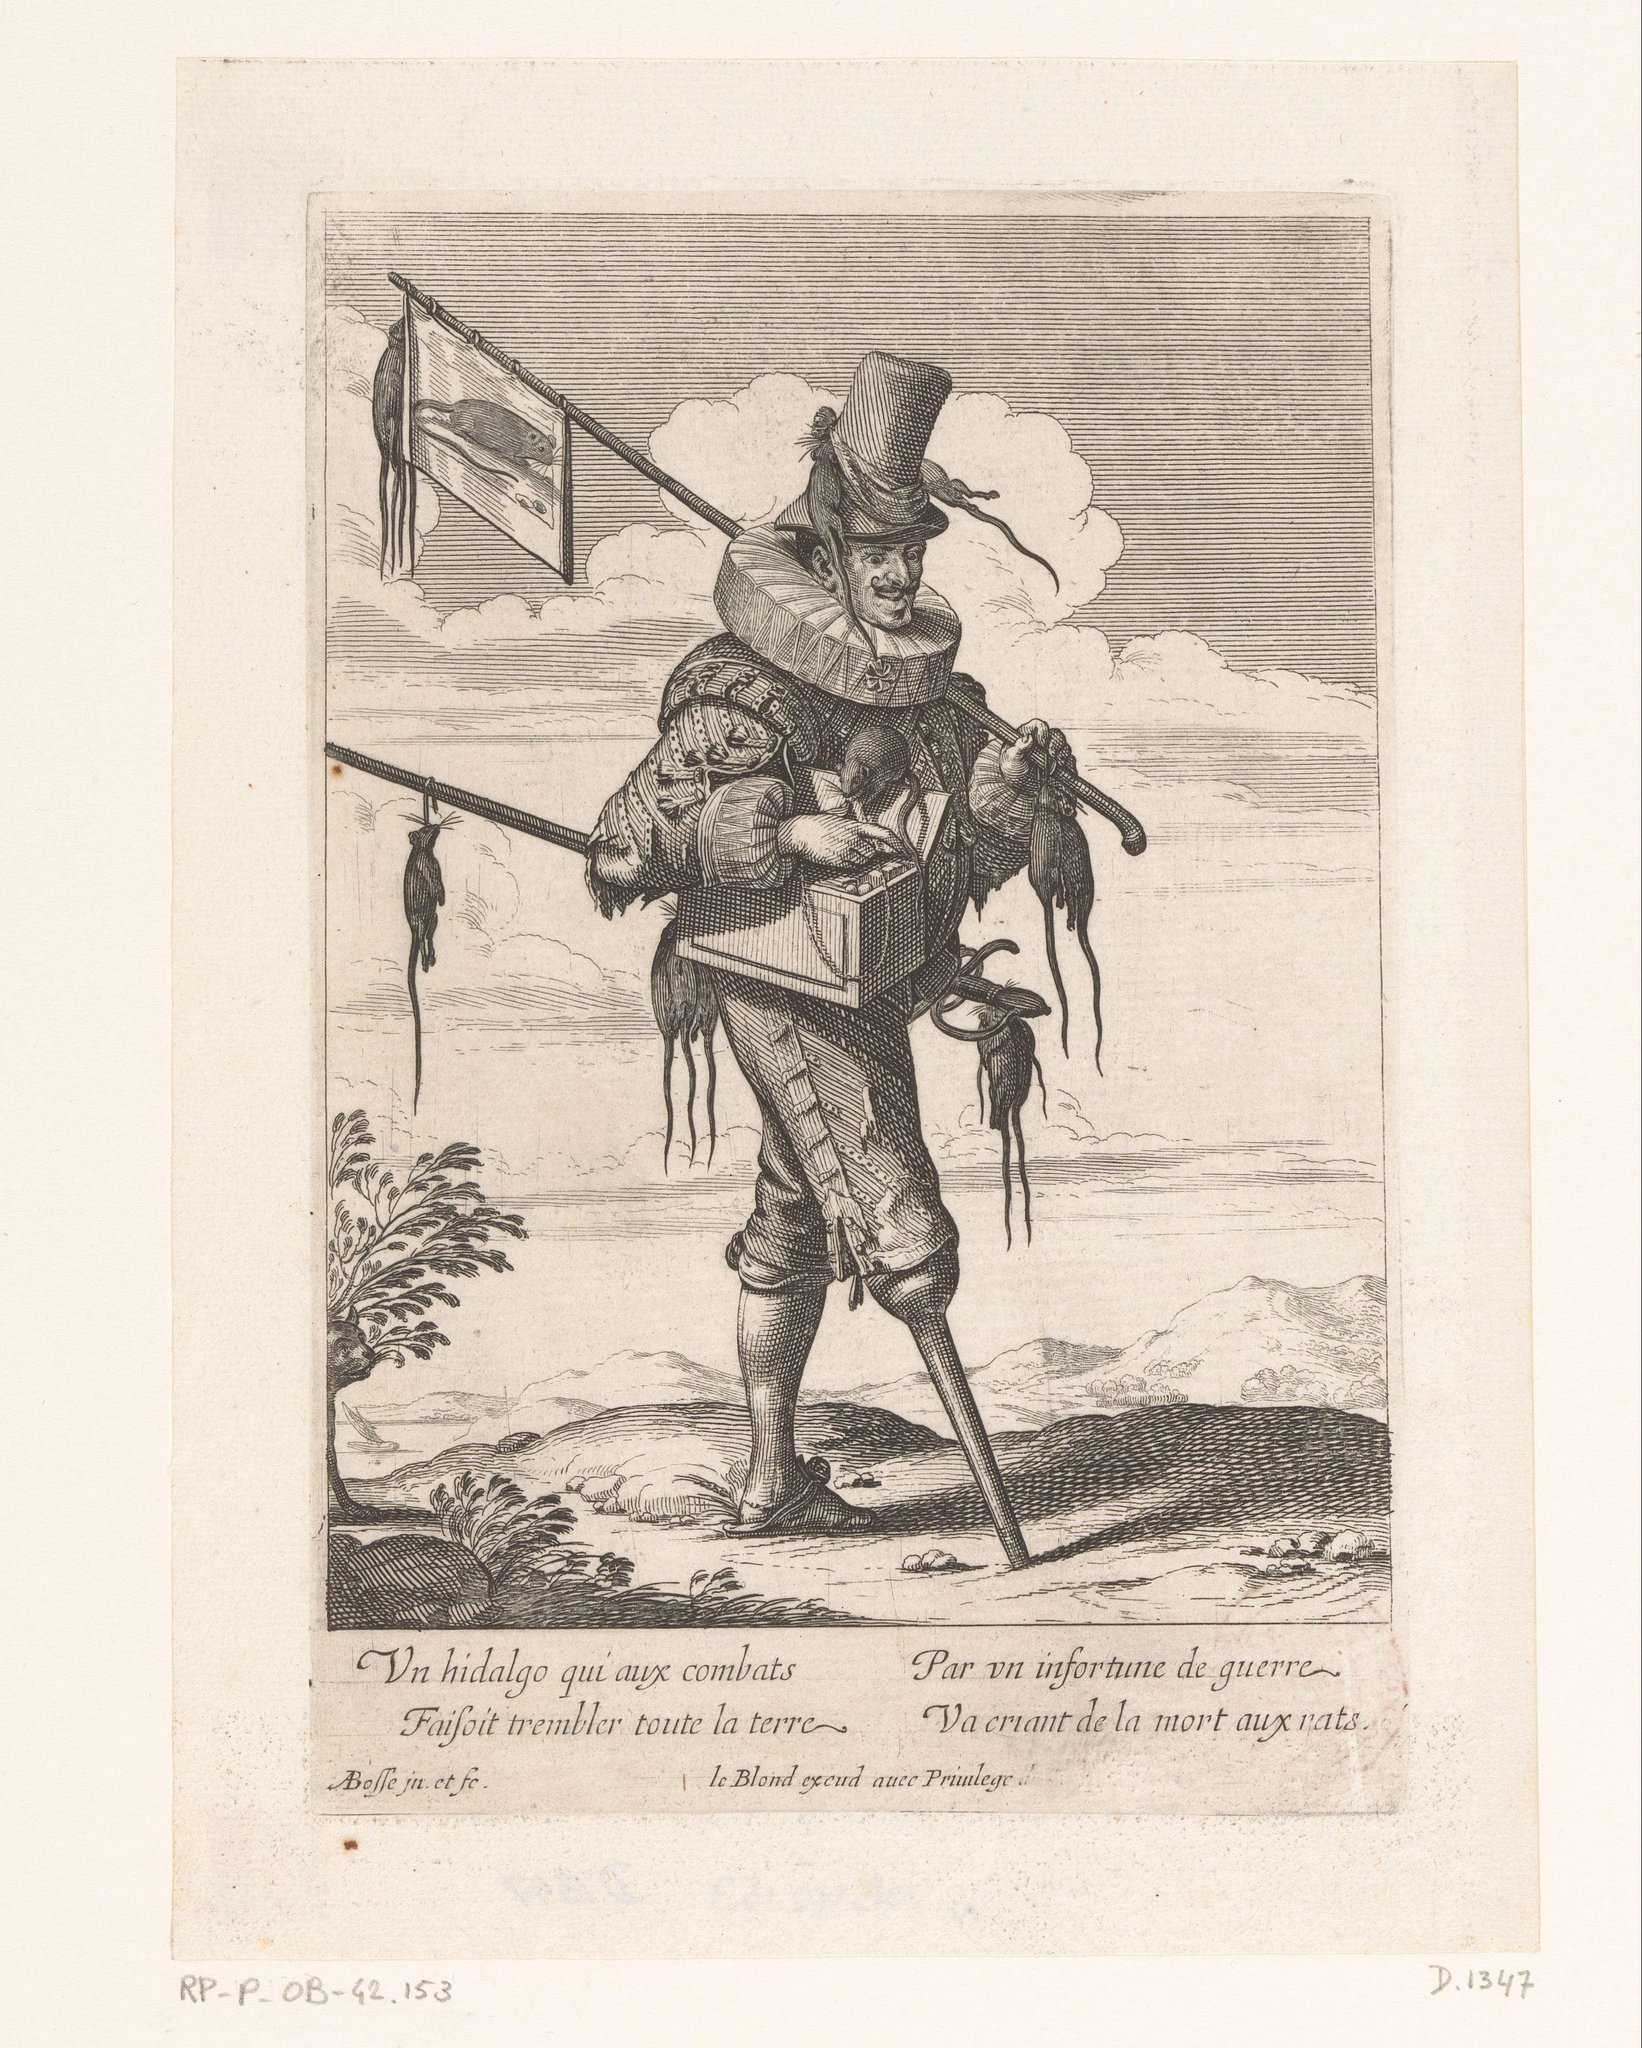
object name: print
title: Spaanse rattenvanger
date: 1629-1630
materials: paper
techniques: engraving, etching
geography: paris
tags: europeans: spaniards, rodents: rat, rat exterminator, wandering or travelling merchant, merchant, salesman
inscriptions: collector's mark: Lugt 240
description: Maakt deel uit van een serie van twaalf prenten met straatverkopers en dienstverleners, uitgegeven door Jean Leblond (I) tussen 1629-1630 te Parijs.